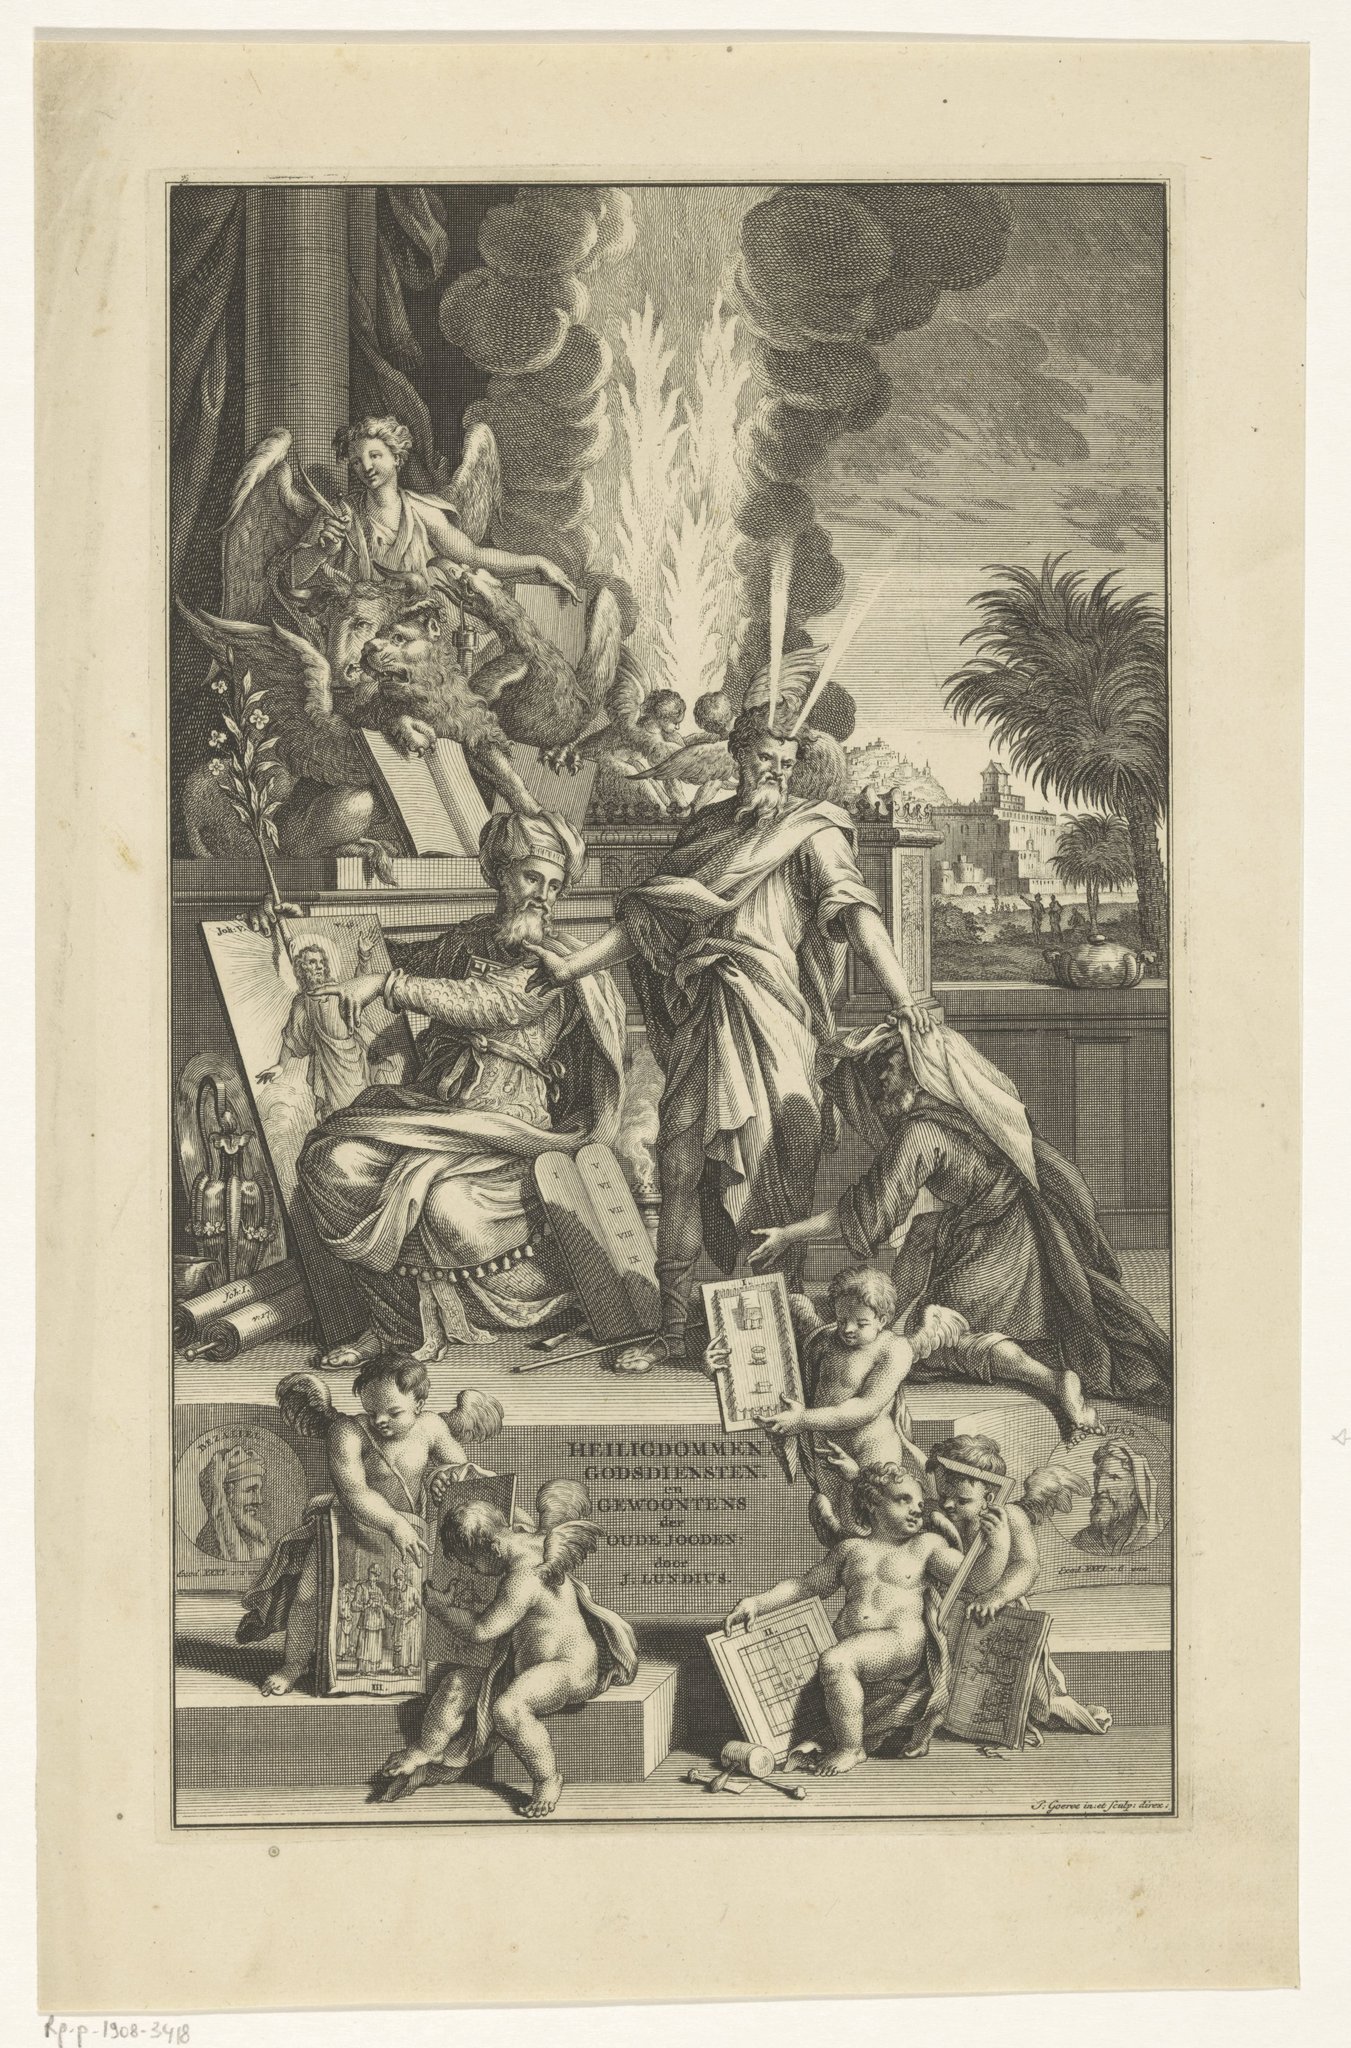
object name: titelblad, titelpagina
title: Titelpagina voor Johannes Lundius, Heiligdommen godsdiensten, en gewoontens der oude jooden, 1726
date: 1726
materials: paper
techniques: engraving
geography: amsterdam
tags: moses (not in biblical context); possible attributes: rays of light or horns on his head, rod, tables of the law, ezekiel (not in biblical context); possible attributes: book or scroll, double wheel, cupids: 'amores', 'amoretti', 'putti', anthropomorphic symbols of the evangelists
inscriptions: collector's mark: Lugt 2228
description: In het midden op een verhoging staat Mozes. Hij legt zijn hand op het hoofd van een man. Naast hem zit de profeet Ezechiël. Hij wijst naar een portret van de verrezen Christus, wiens komst hij voorspelde. Op de achtergrond de vier apocalyptische dieren uit zijn visioen. Op de voorgrond verschillende putti die prenten tonen met voorstellingen van elementen uit de Joodse godsdienst.